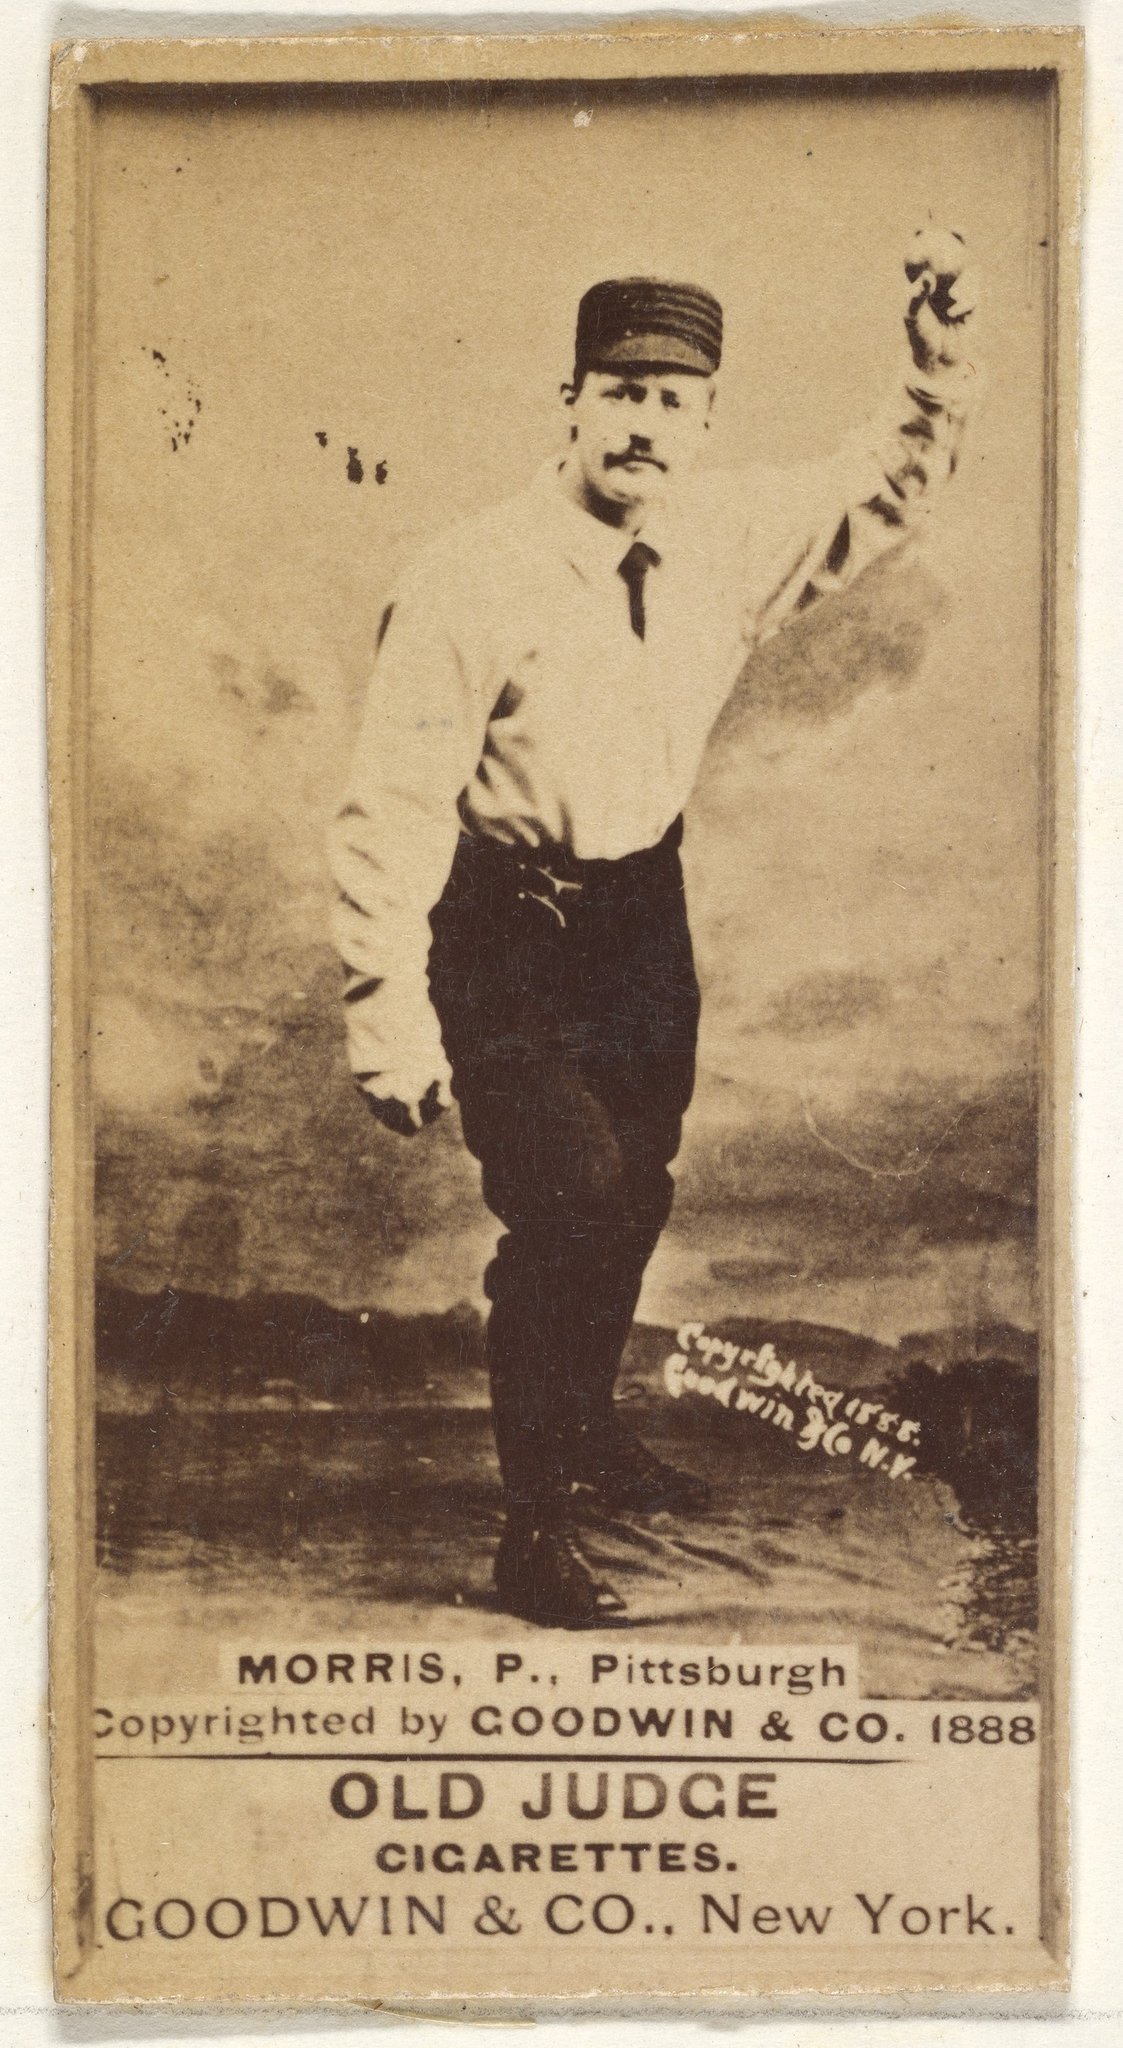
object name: baseball card, photograph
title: Ed Morris, Pitcher, Pittsburgh, from the Old Judge series (N172) for Old Judge Cigarettes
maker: goodwin & company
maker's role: publisher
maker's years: 1850-1950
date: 1888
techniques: albumen silver print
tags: men,portraits,baseball,athletes